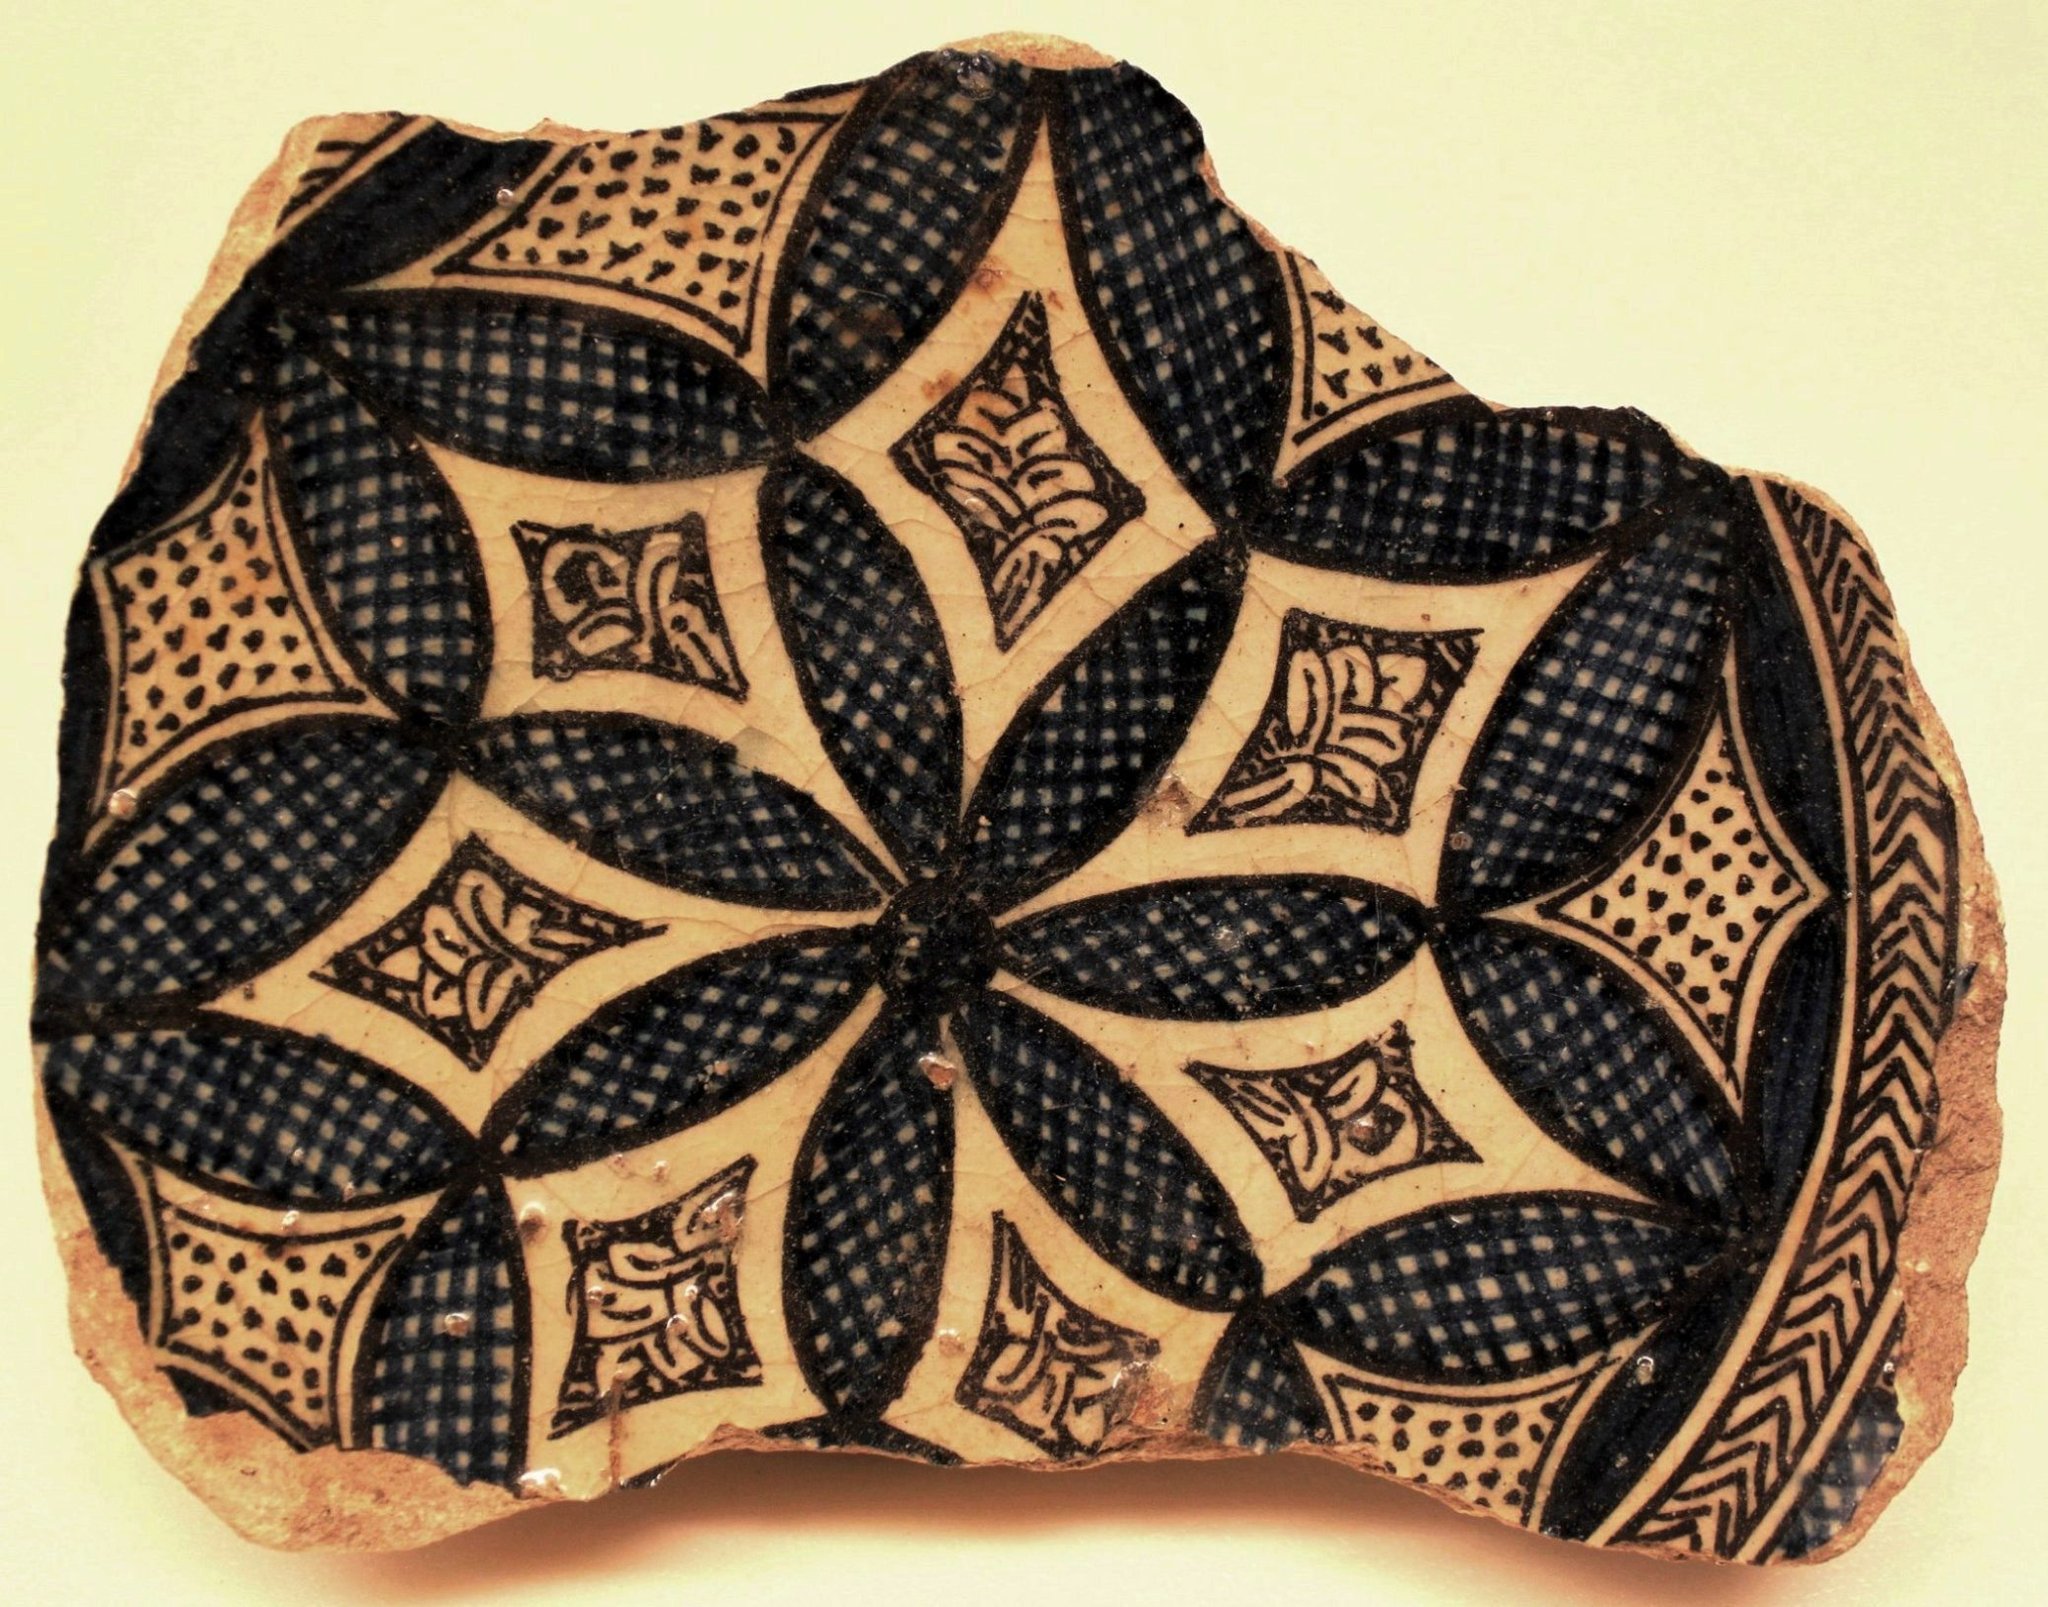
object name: fragment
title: Fragment of a Dish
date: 1301-1400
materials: glaze, stonepaste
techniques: painting, polychrome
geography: egypt or syria